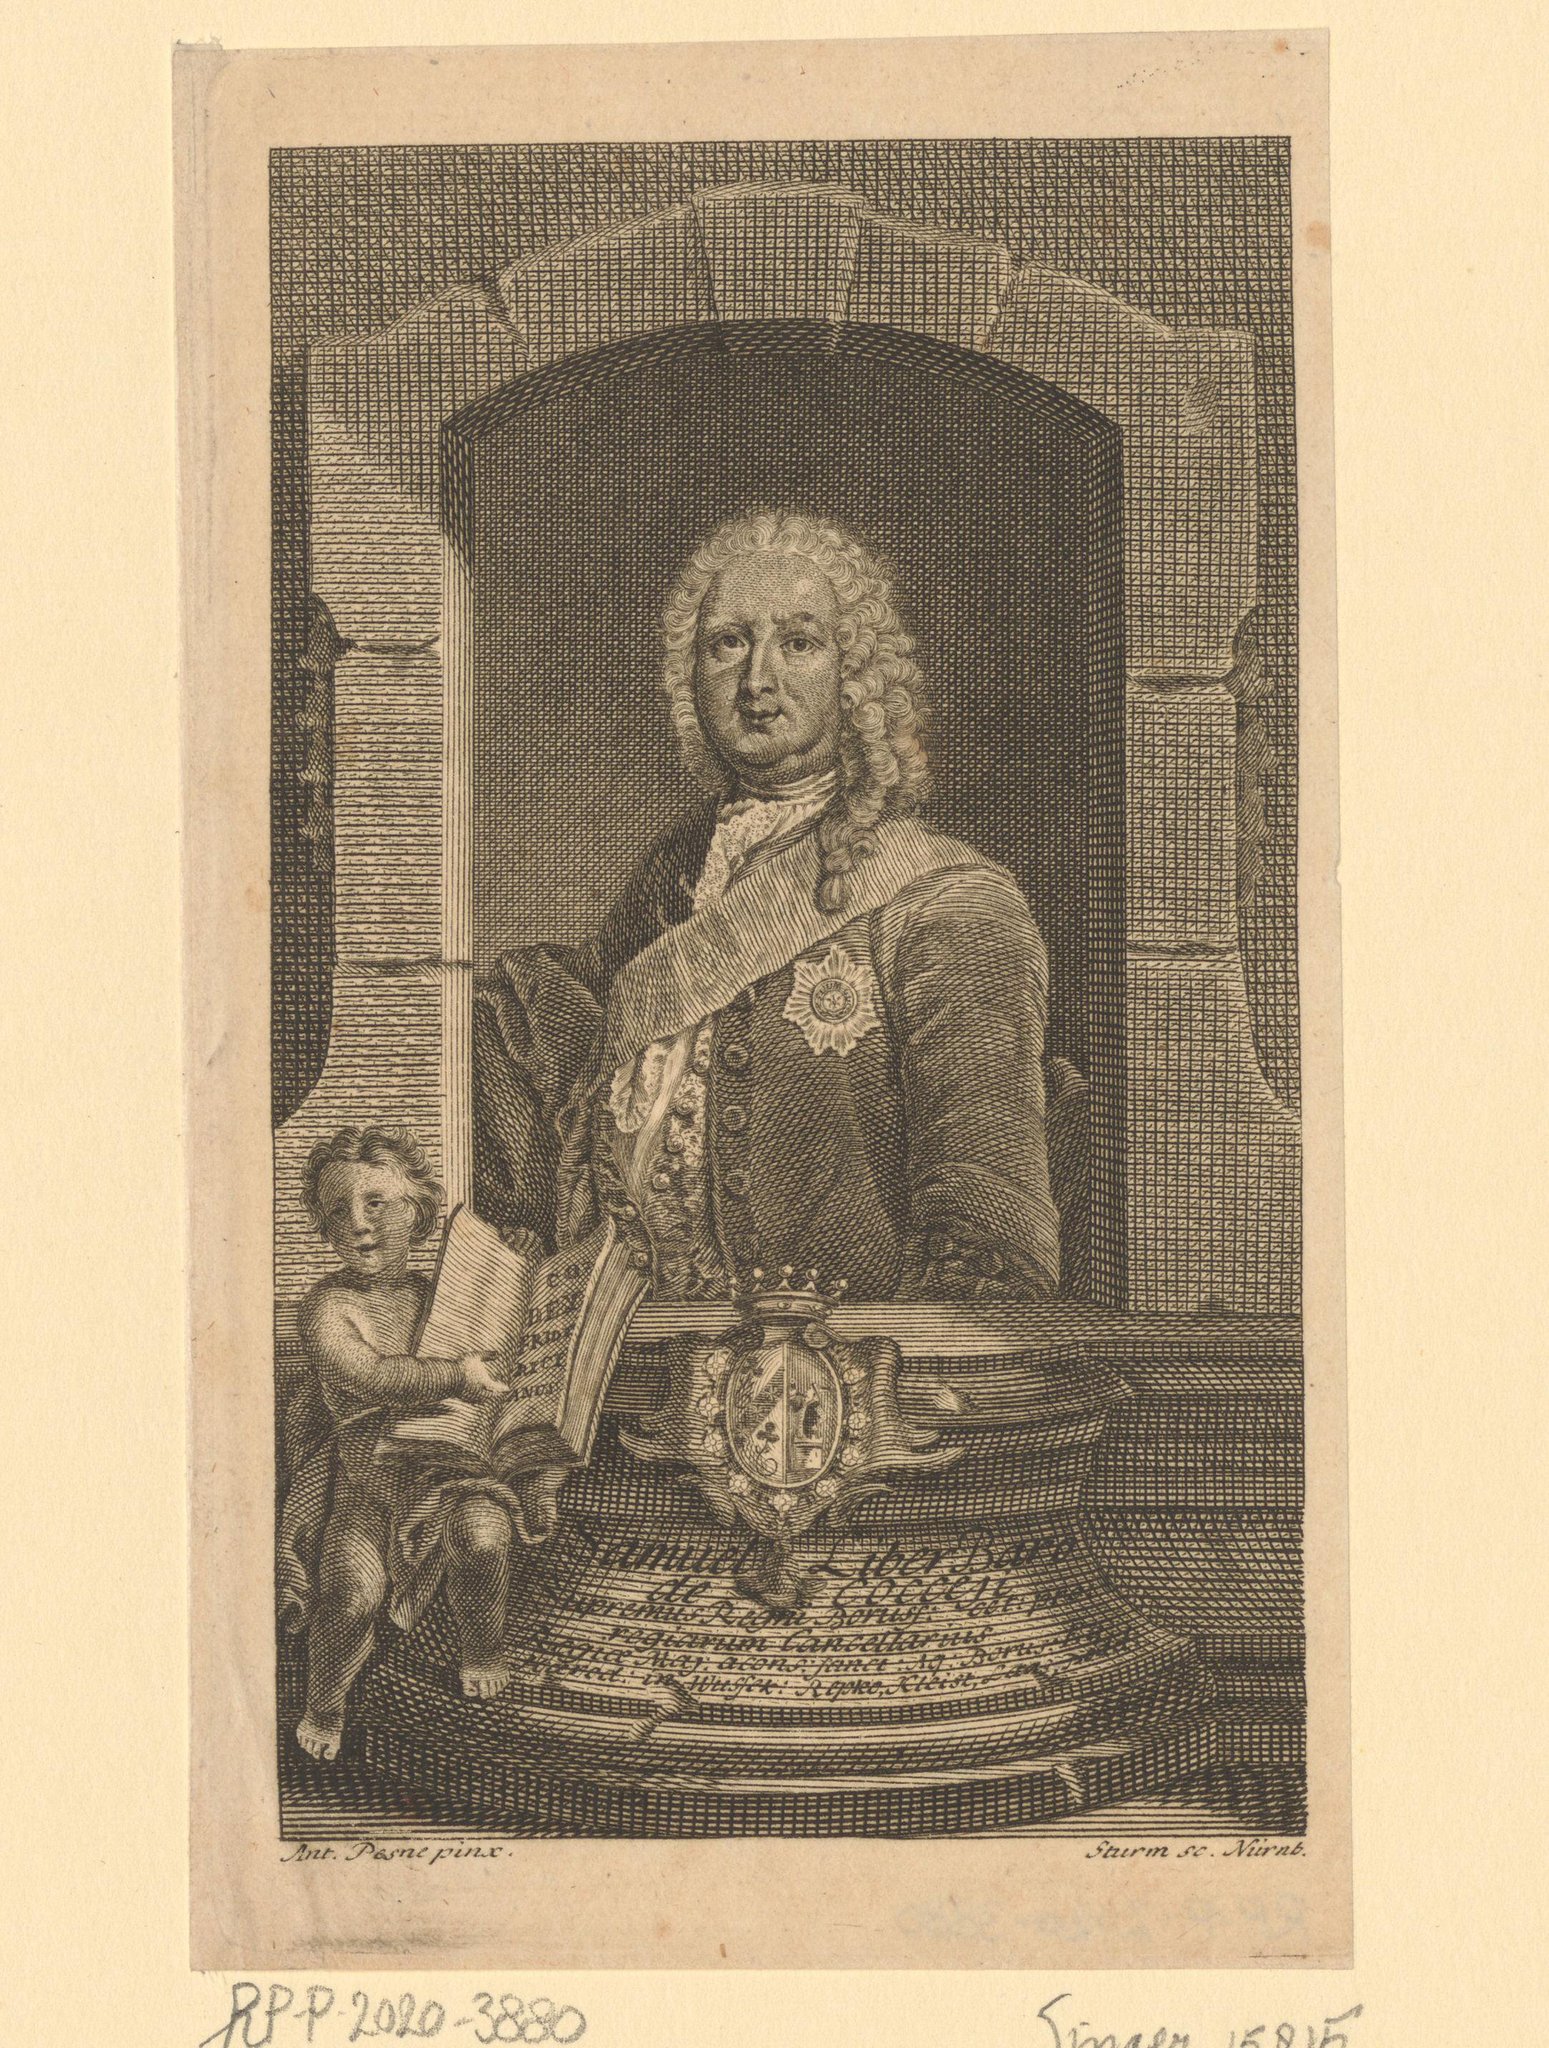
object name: print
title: Portret van Samuel Freiherr von Cocceji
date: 1752-1793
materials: paper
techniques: engraving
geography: nuremberg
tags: berlin, historical persons, cupids: 'amores', 'amoretti', 'putti'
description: Onder het portret een putto met een boek.